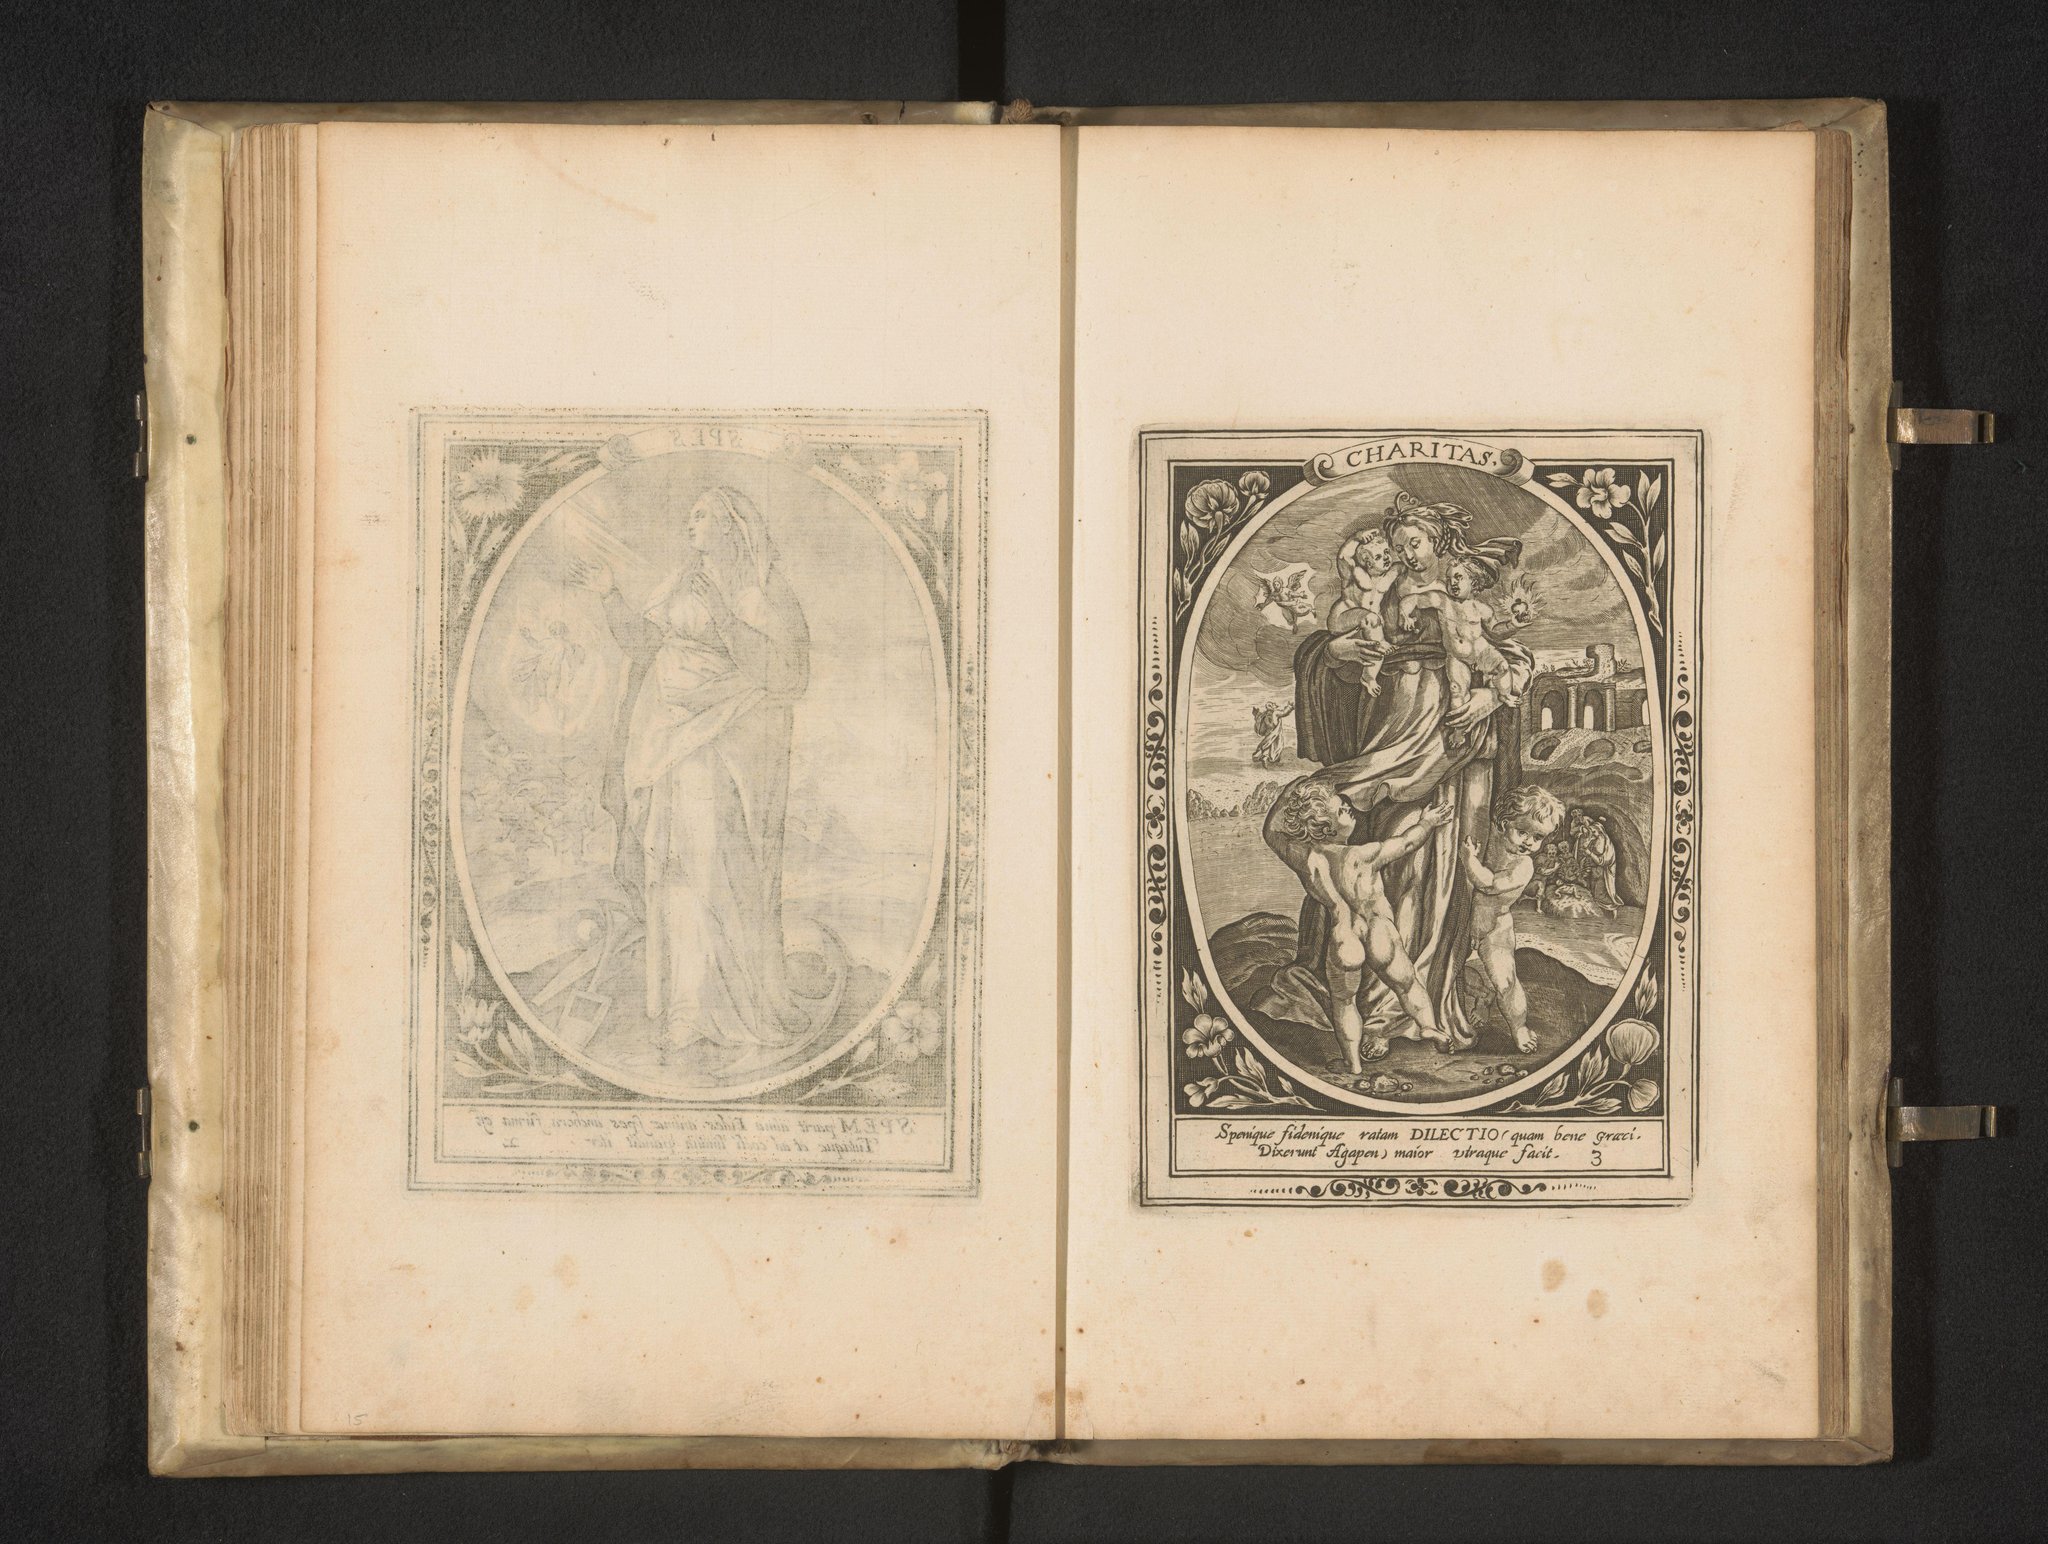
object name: print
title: Liefde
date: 1600-1670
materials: paper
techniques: engraving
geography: paris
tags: charity, 'caritas'; 'carità' (ripa) ~ one of the three theological virtues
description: De Liefde (Caritas). Genummered rechtsonder: 3. Onderdeel van de serie van zeven theologische en kardinale deugden. Onderdeel van een album met voornamelijk christelijke voorstellingen.